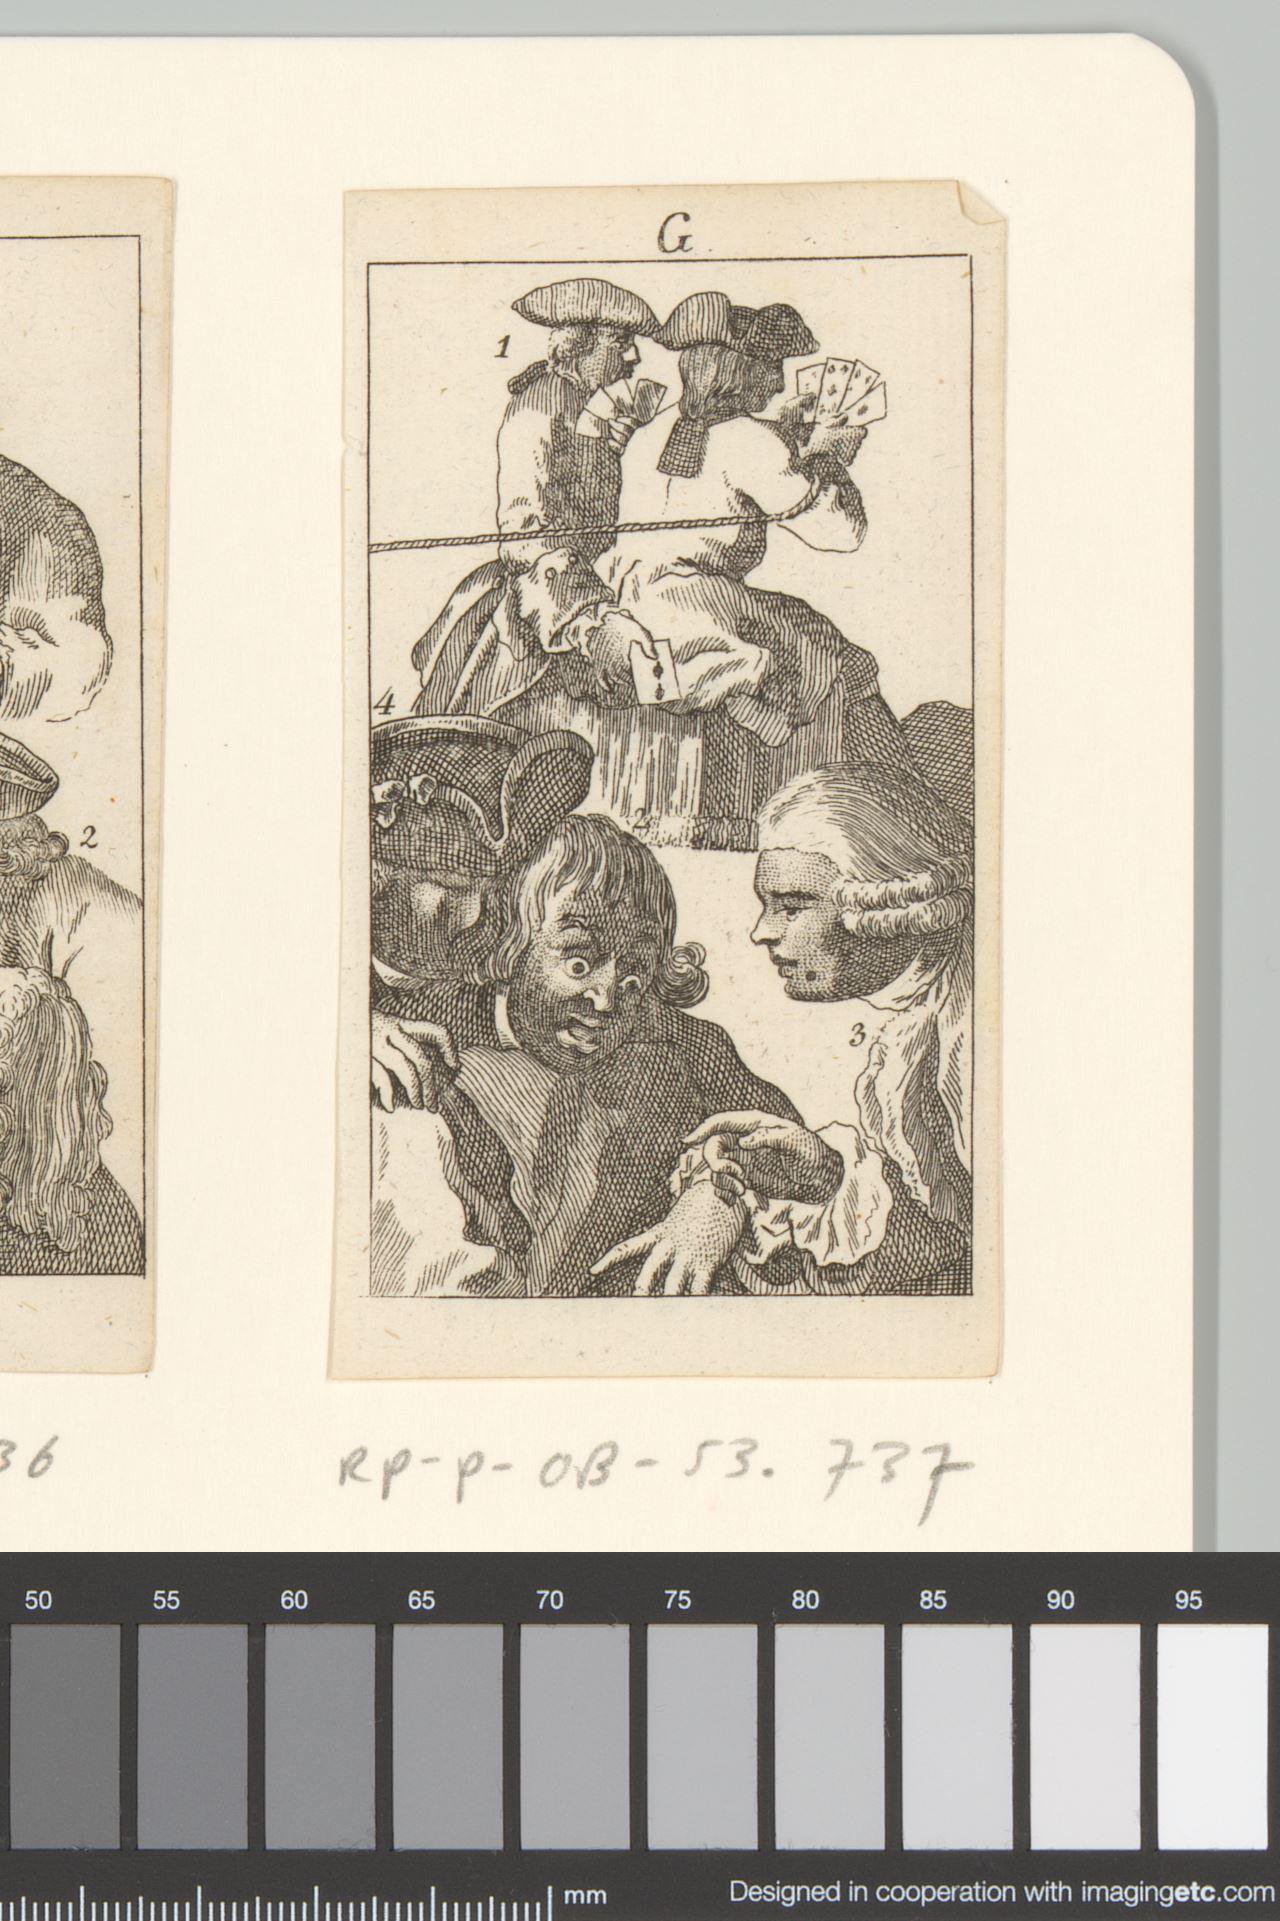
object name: print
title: Elf schetsen en studies van personen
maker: ernst ludwig riepenhausen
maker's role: print maker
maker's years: 1765-1840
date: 1775-1840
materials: paper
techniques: etching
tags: adult man, playing-cards, the soldier; the soldier's life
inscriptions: collector's mark: Lugt 2228